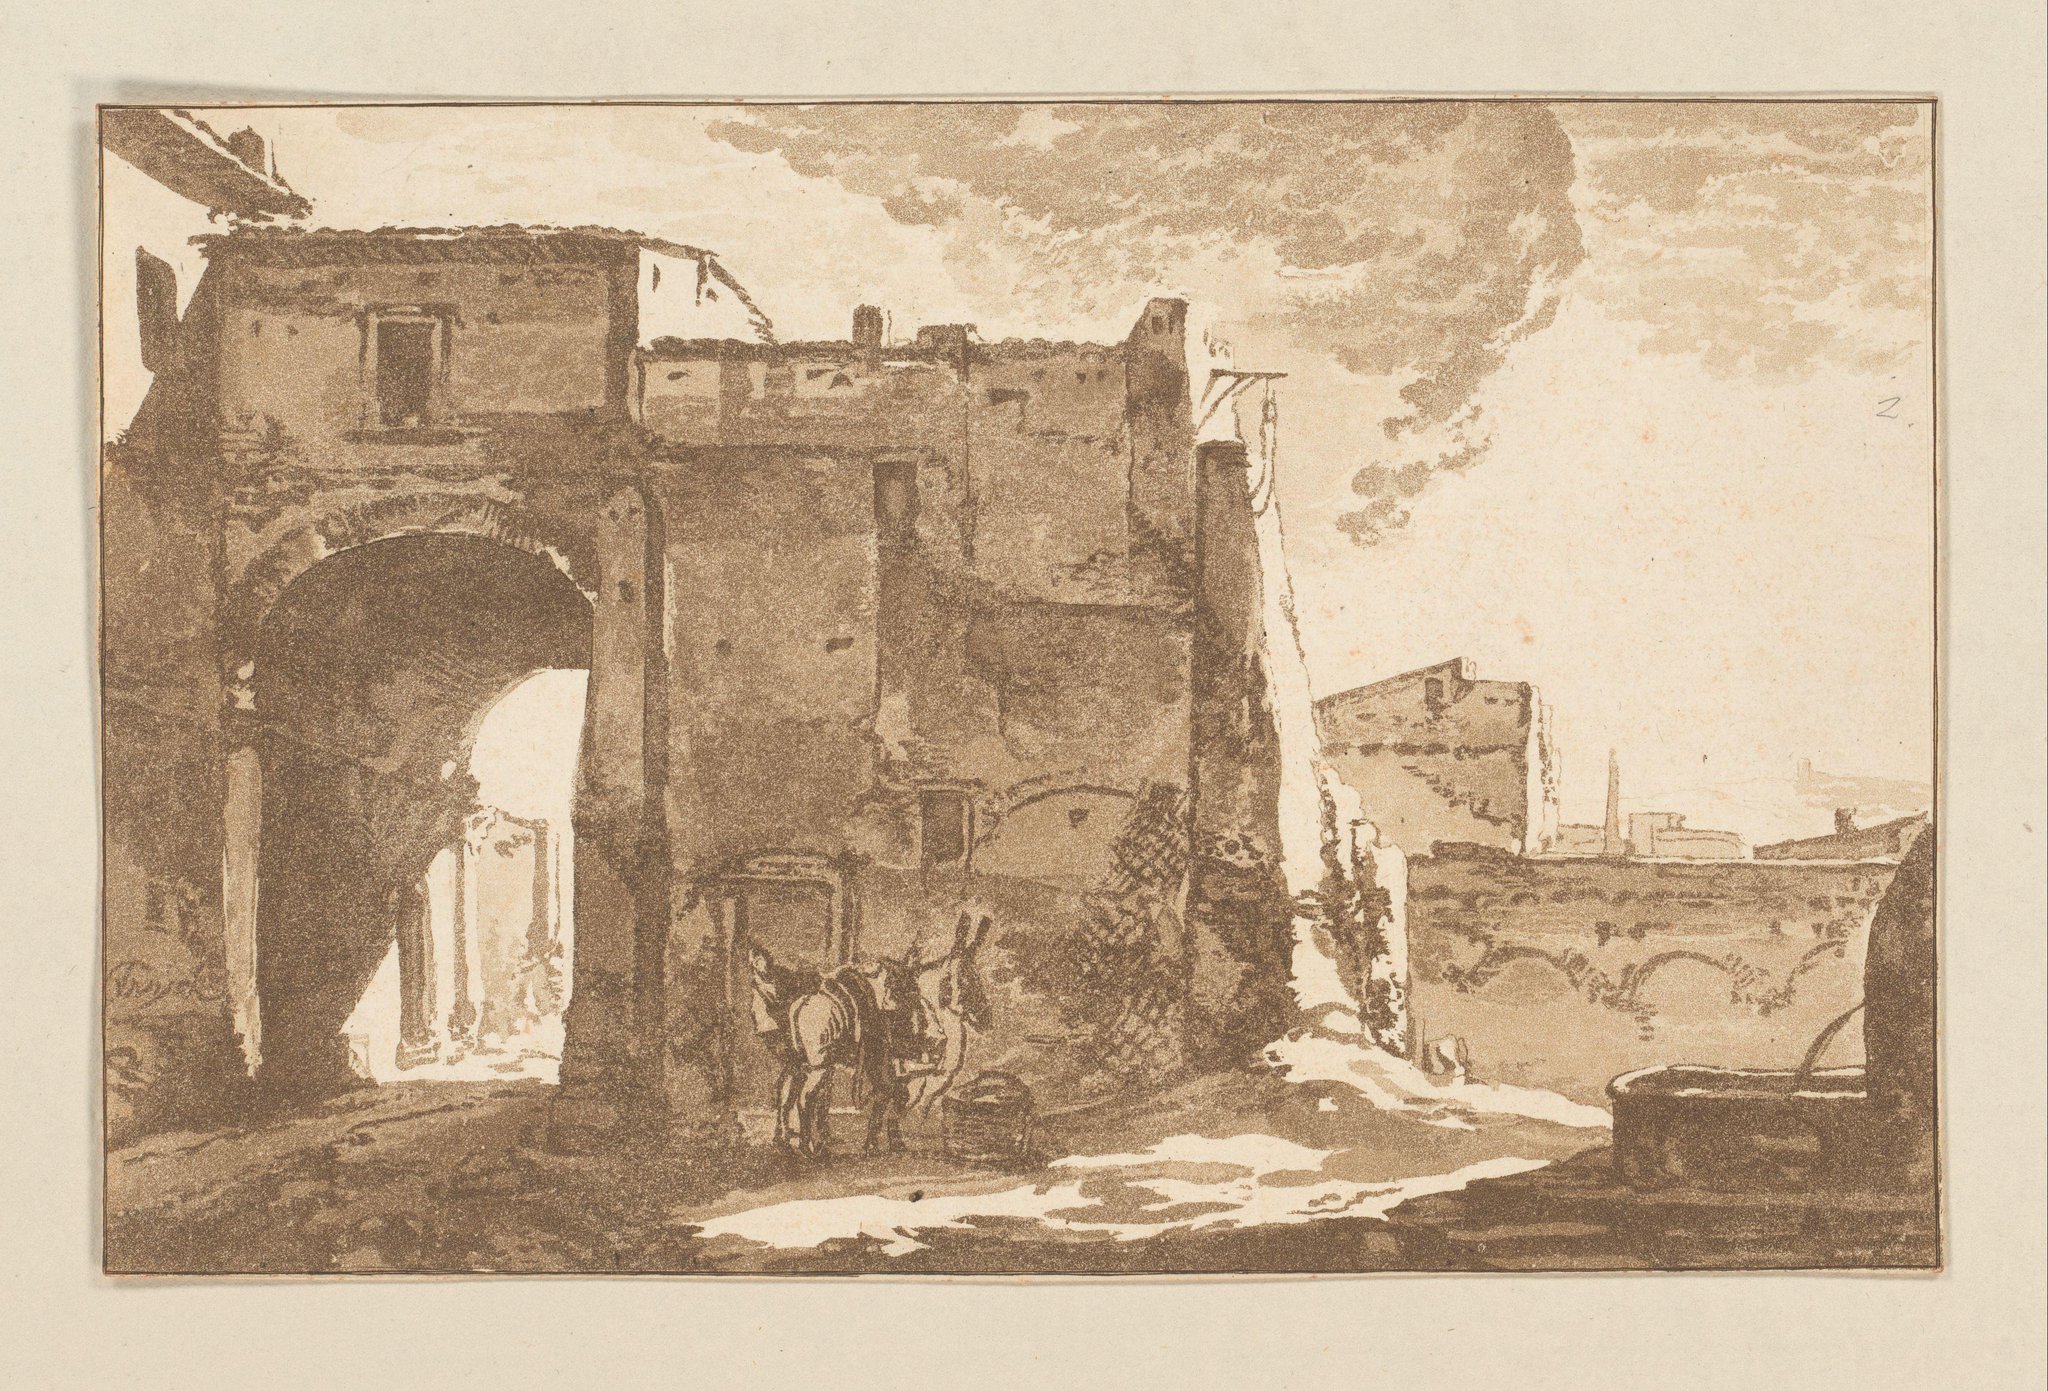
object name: print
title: Poort met reiziger en muildier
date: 1781-1782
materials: paper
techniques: etching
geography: amsterdam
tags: city-view, and landscape with man-made constructions, mule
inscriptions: collector's mark: ‘RIJKS / MUSM’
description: Bij een poort staan een man en een muildier. Rechts een waterbron. De prent ligt los in een album.